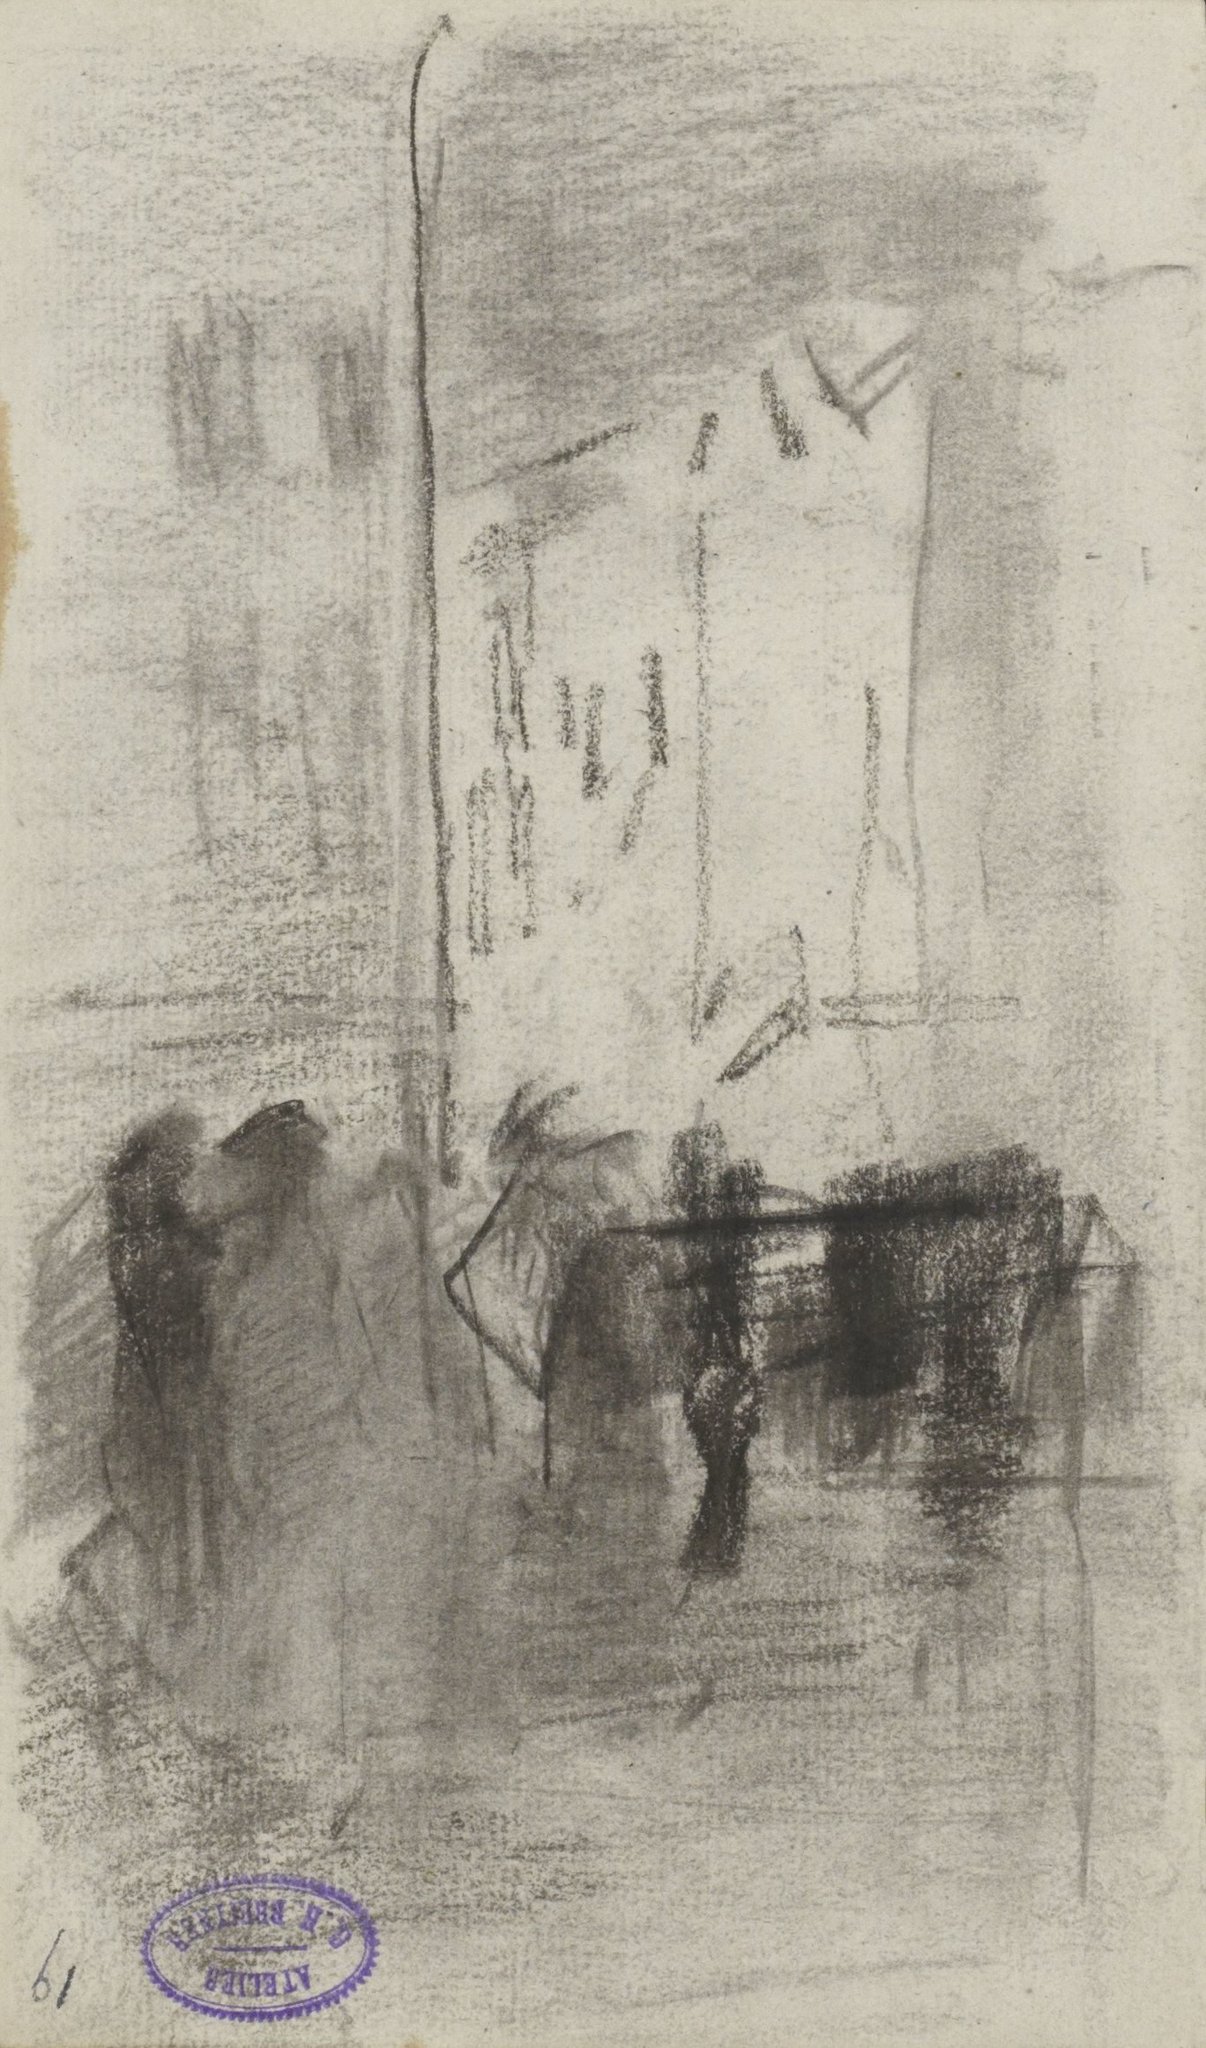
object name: drawing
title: Stadsgezicht met figuren, mogelijk in Amsterdam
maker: george hendrik breitner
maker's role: draughtsman, painter, print maker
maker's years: 1857-1923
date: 1882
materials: chalk, charcoal, paper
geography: amsterdam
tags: urban housing, city-view, and landscape with man-made constructions (+ city(-scape) with figures, staffage), amsterdam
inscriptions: workshop stamp: Lugt 291d